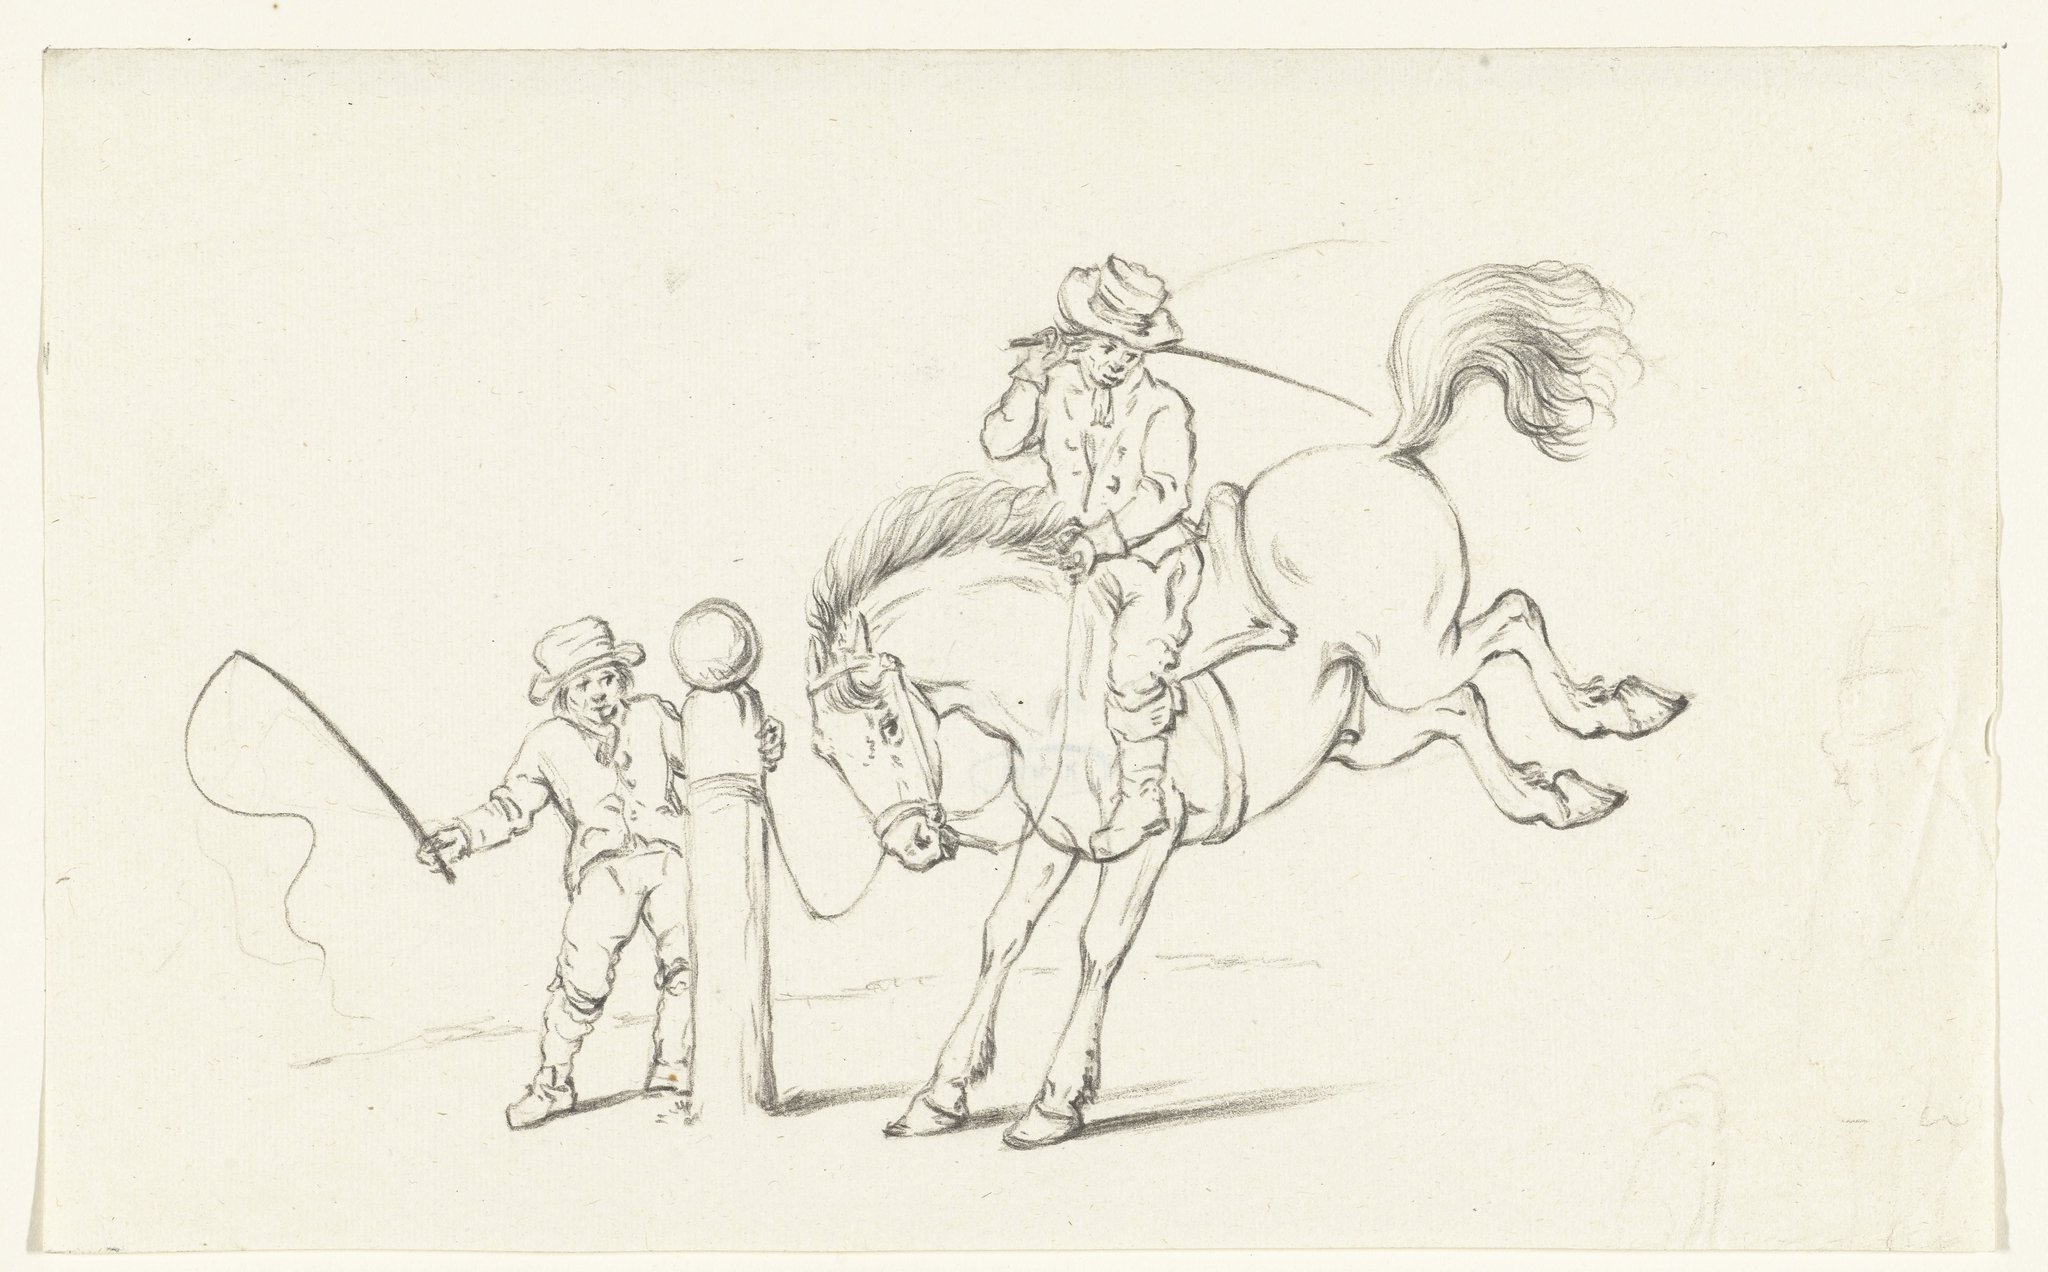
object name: drawing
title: Het temmen van een paard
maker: jean bernard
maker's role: draughtsman, print maker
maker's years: 1765-1833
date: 1775-1833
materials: chalk, paper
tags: breaking to saddle, bridle, etc. ~ wild horses, horse, kicking (horse in motion)